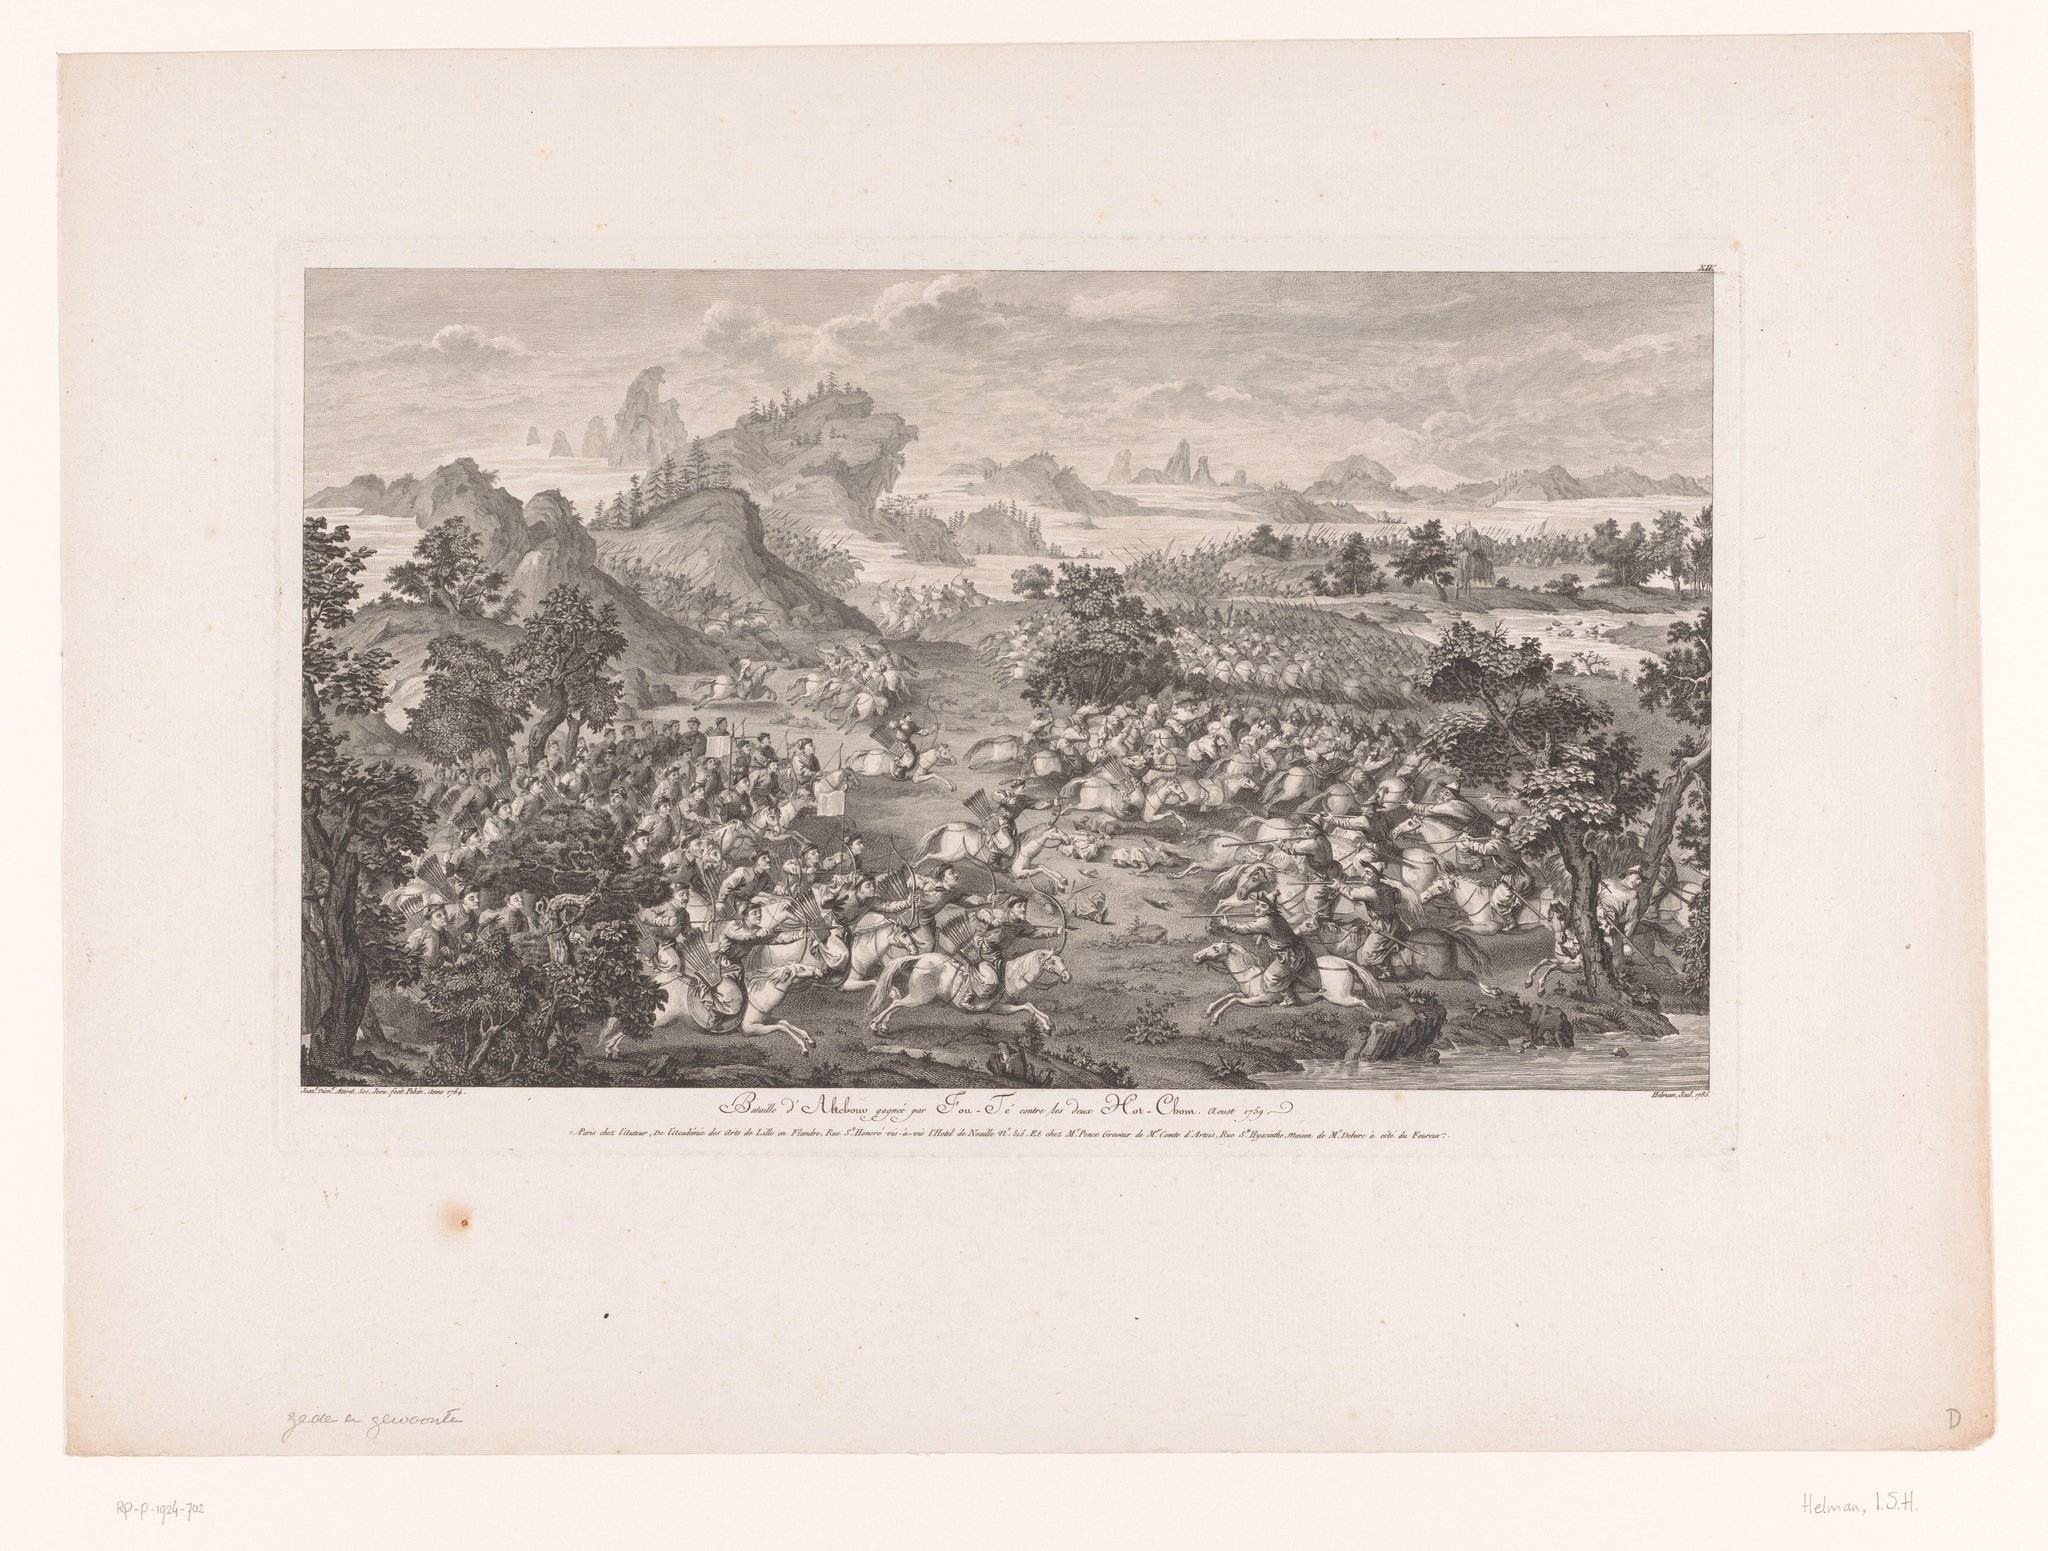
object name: print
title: Conquêtes de l'Empereur de la Chine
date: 1785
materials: paper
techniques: engraving, etching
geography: paris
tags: battle (+ artillery), battle, battle (+ cavalry, horsemen)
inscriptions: collector's mark: Lugt 2233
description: Prent uit een versie van de serie 'Conquêtes de l'Empereur de la Chine' met afbeeldingen van de veroveringen van keizer Qianlong van China, uitgegeven door Helman tussen 1783-1785. Voor twee bladen met bijbehorende beschrijvende tekst, zie RP-P-OB-43.629 en RP-P-OB-43.630.